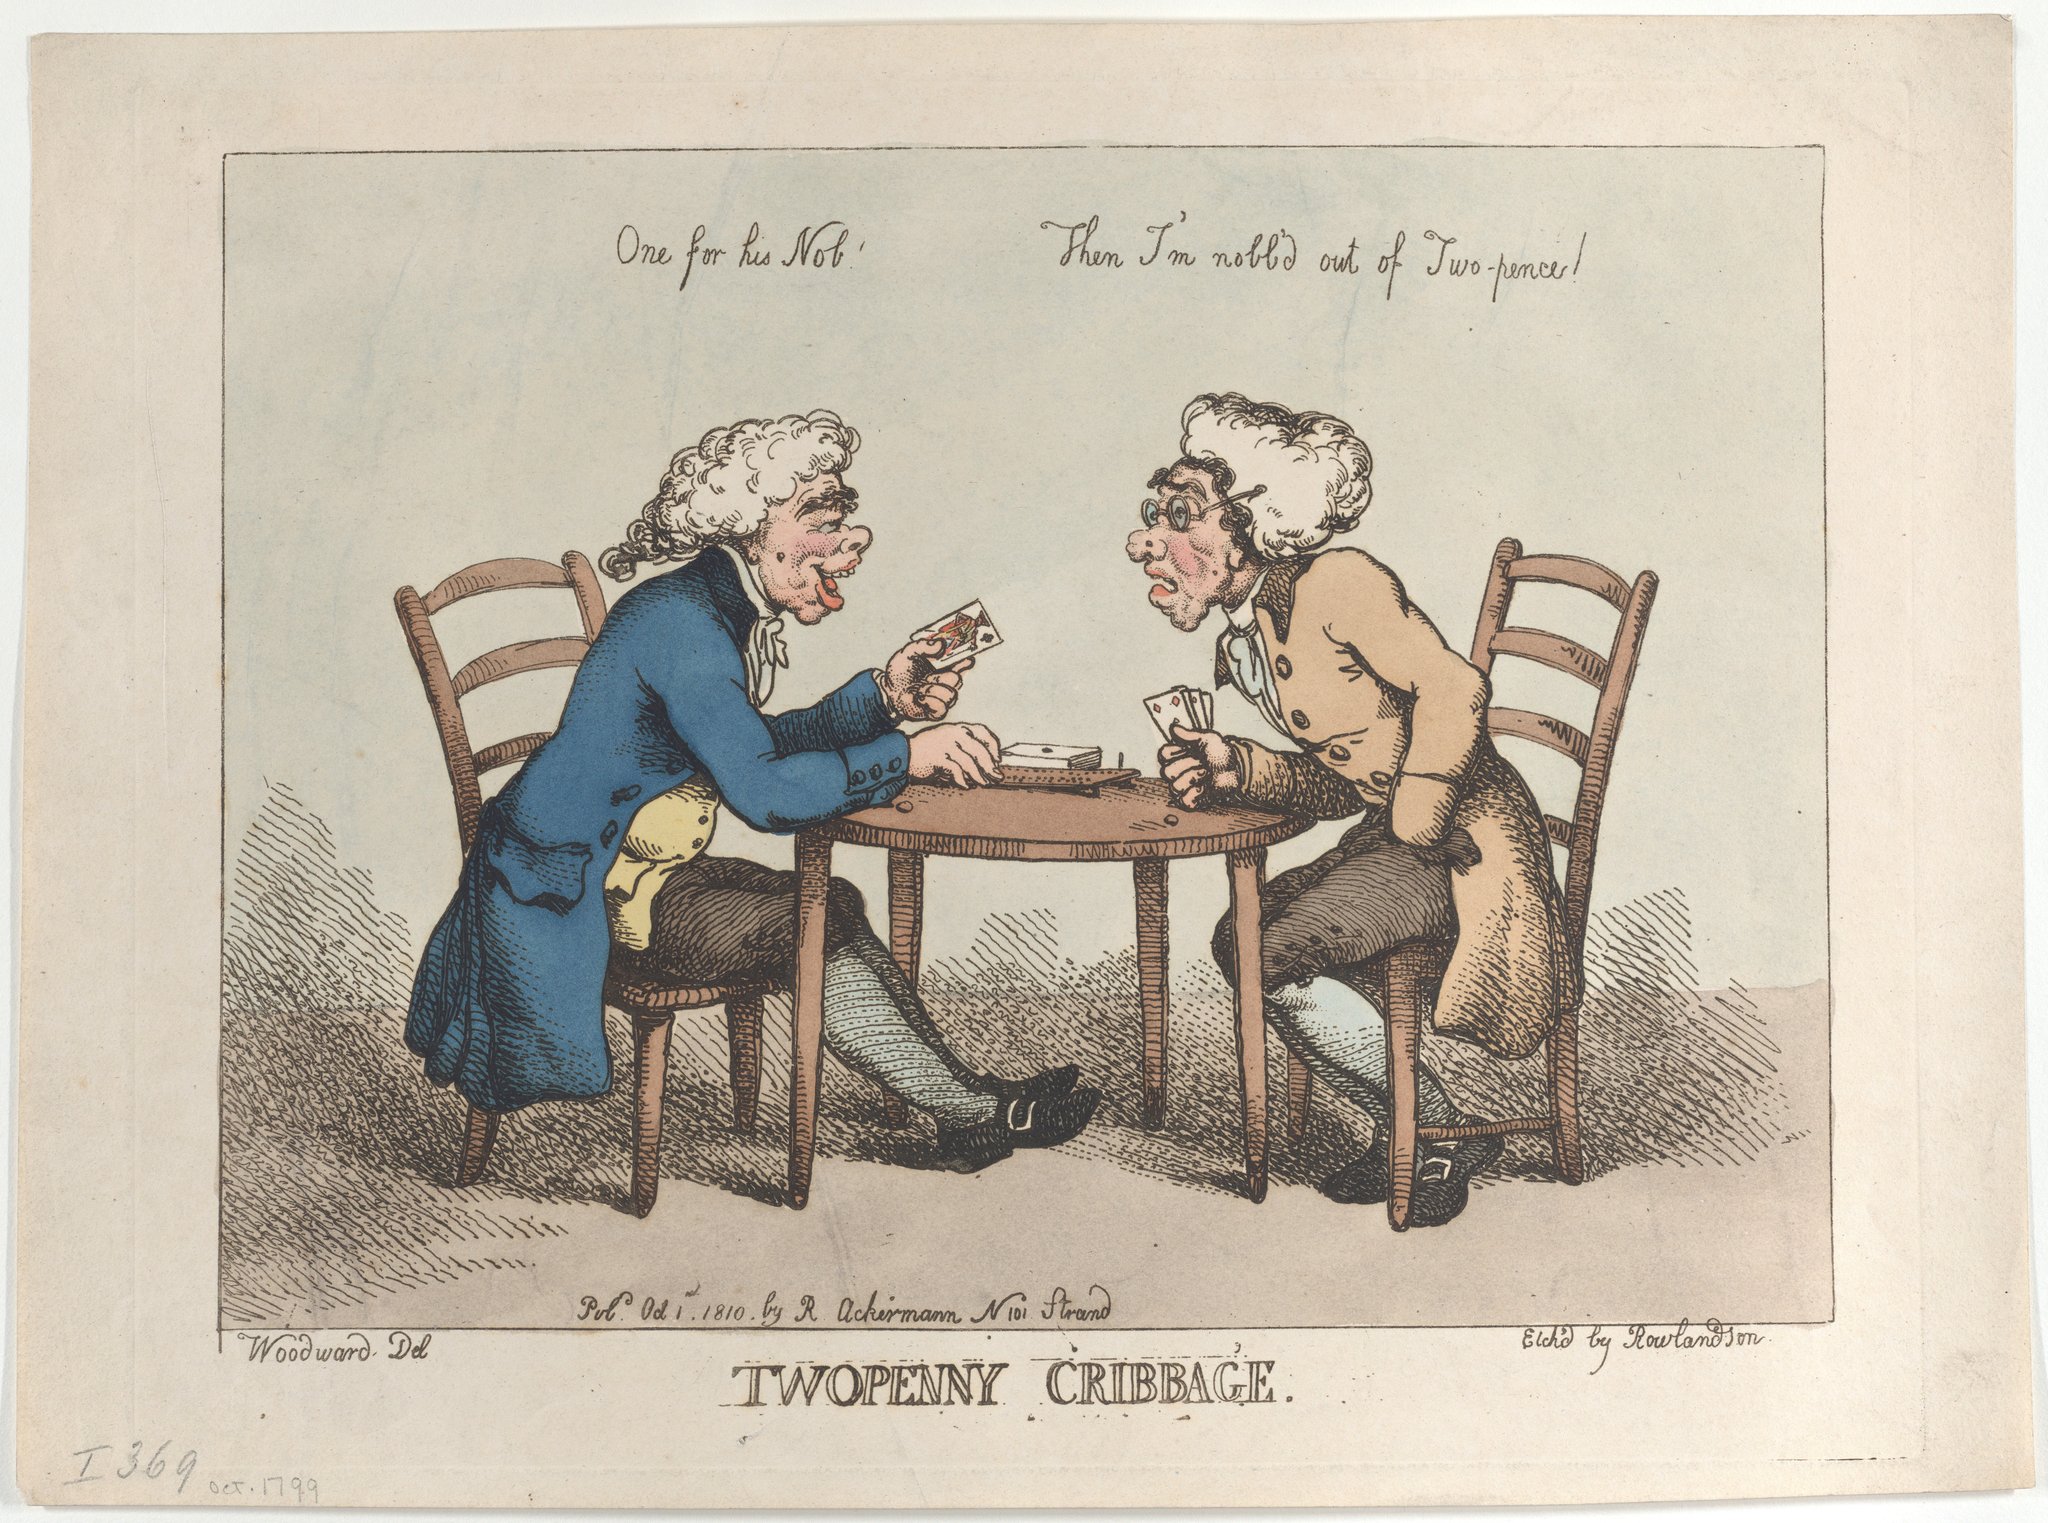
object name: print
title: Twopenny Cribbage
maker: thomas rowlandson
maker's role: artist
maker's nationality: british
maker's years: 1757-1827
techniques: etching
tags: satire,men,playing cards,games